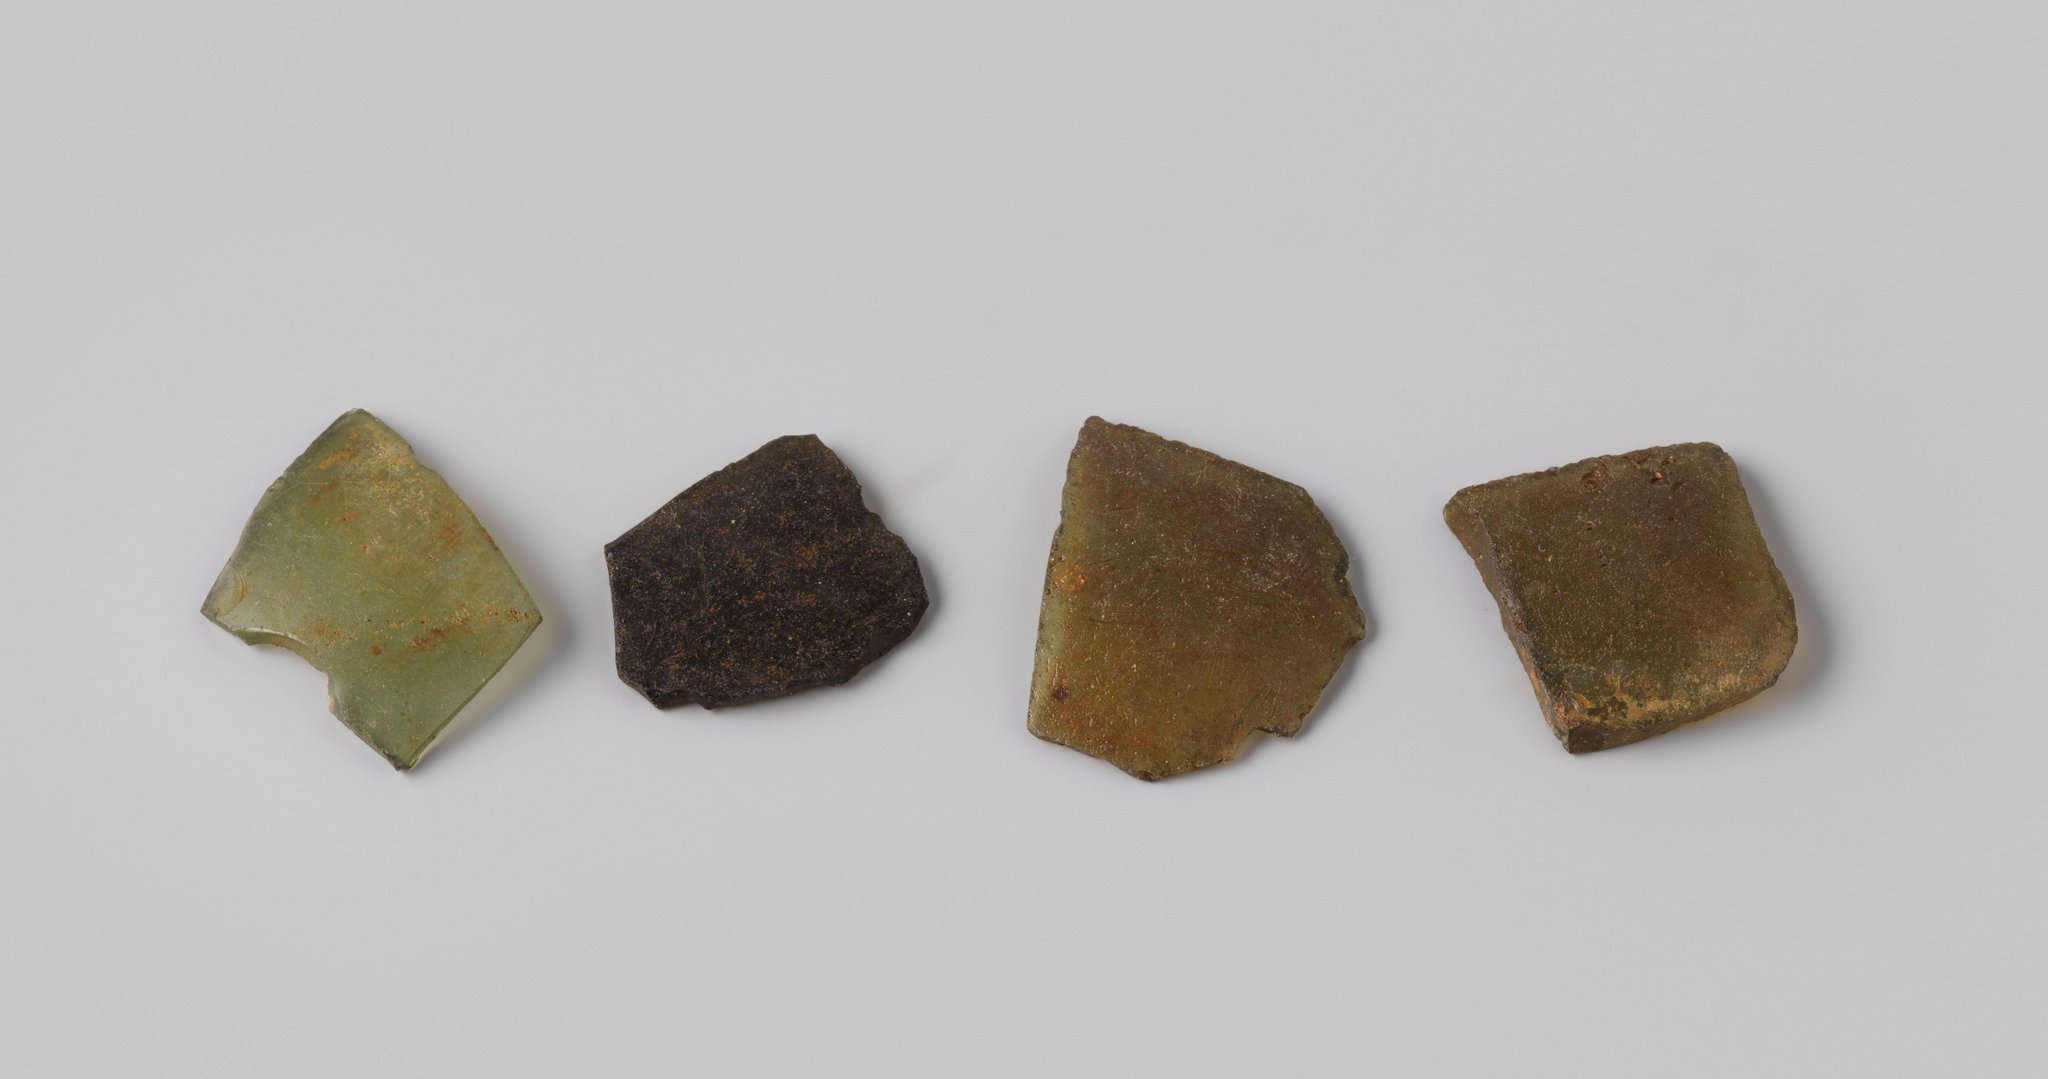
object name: wine bottle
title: Scherven van wijnflessen uit het wrak van de Oost-Indiëvaarder Hollandia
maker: Anonymous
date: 1700-1743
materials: glass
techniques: green glass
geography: netherlands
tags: verenigde oostindische compagnie, hollandia (schip)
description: Typologically not identifiable, belly, fragment.